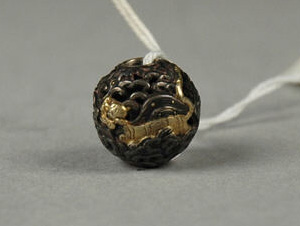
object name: ojime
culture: japanese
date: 1801-1900